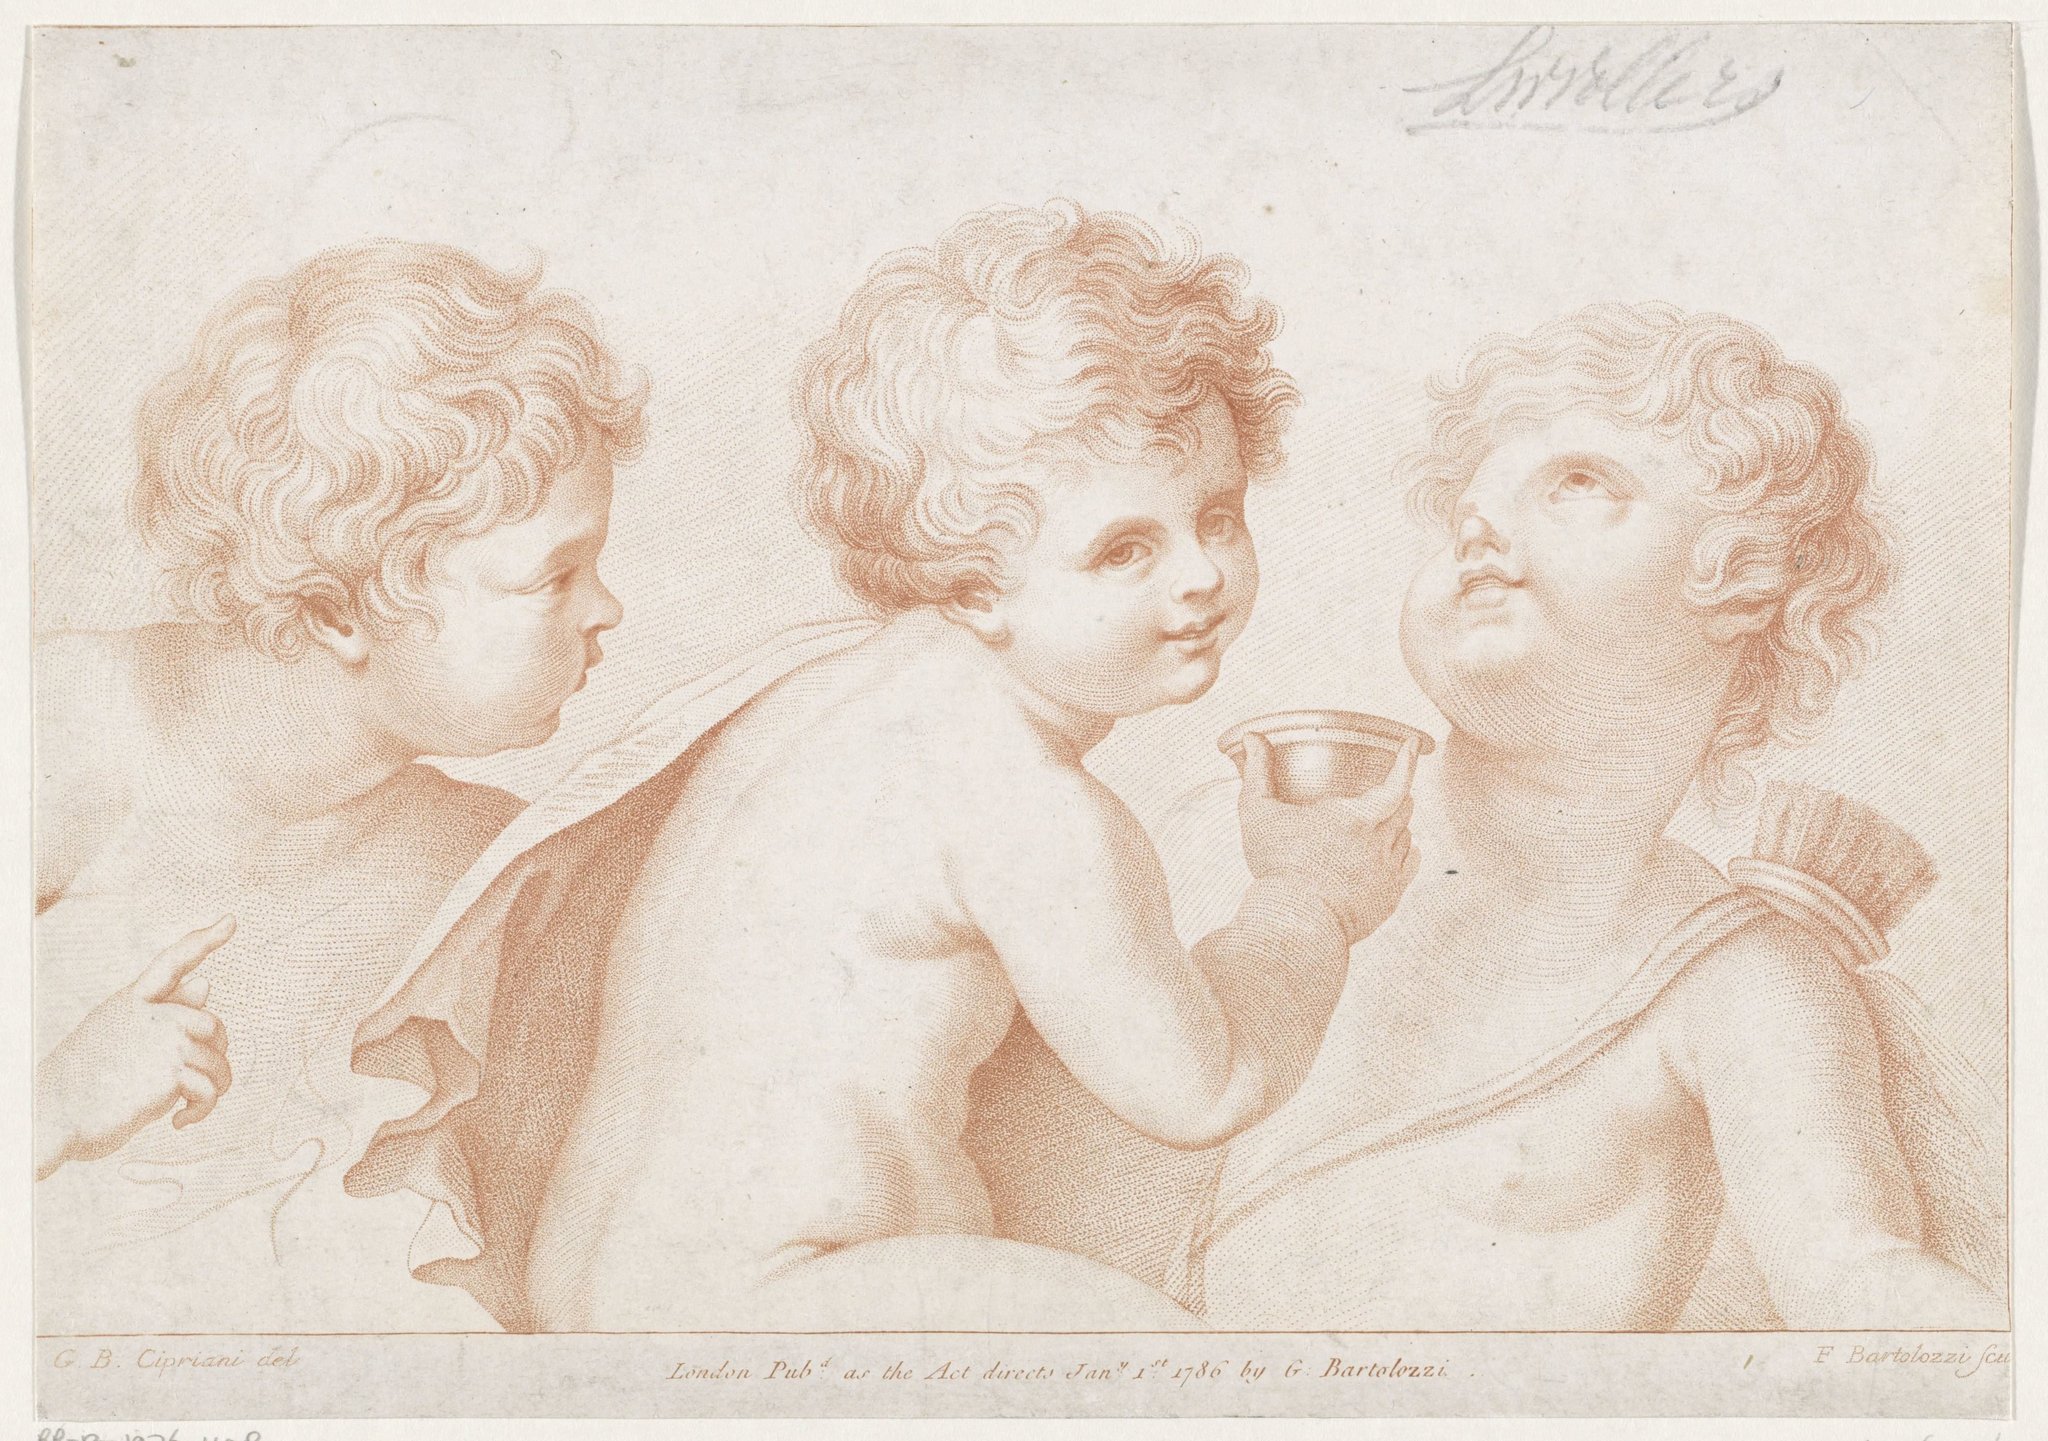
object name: print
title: Ciprianis rudiments of drawing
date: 1786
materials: paper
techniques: etching, engraving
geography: london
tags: cupids: 'amores', 'amoretti', 'putti'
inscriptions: collector's mark: Lugt 2228